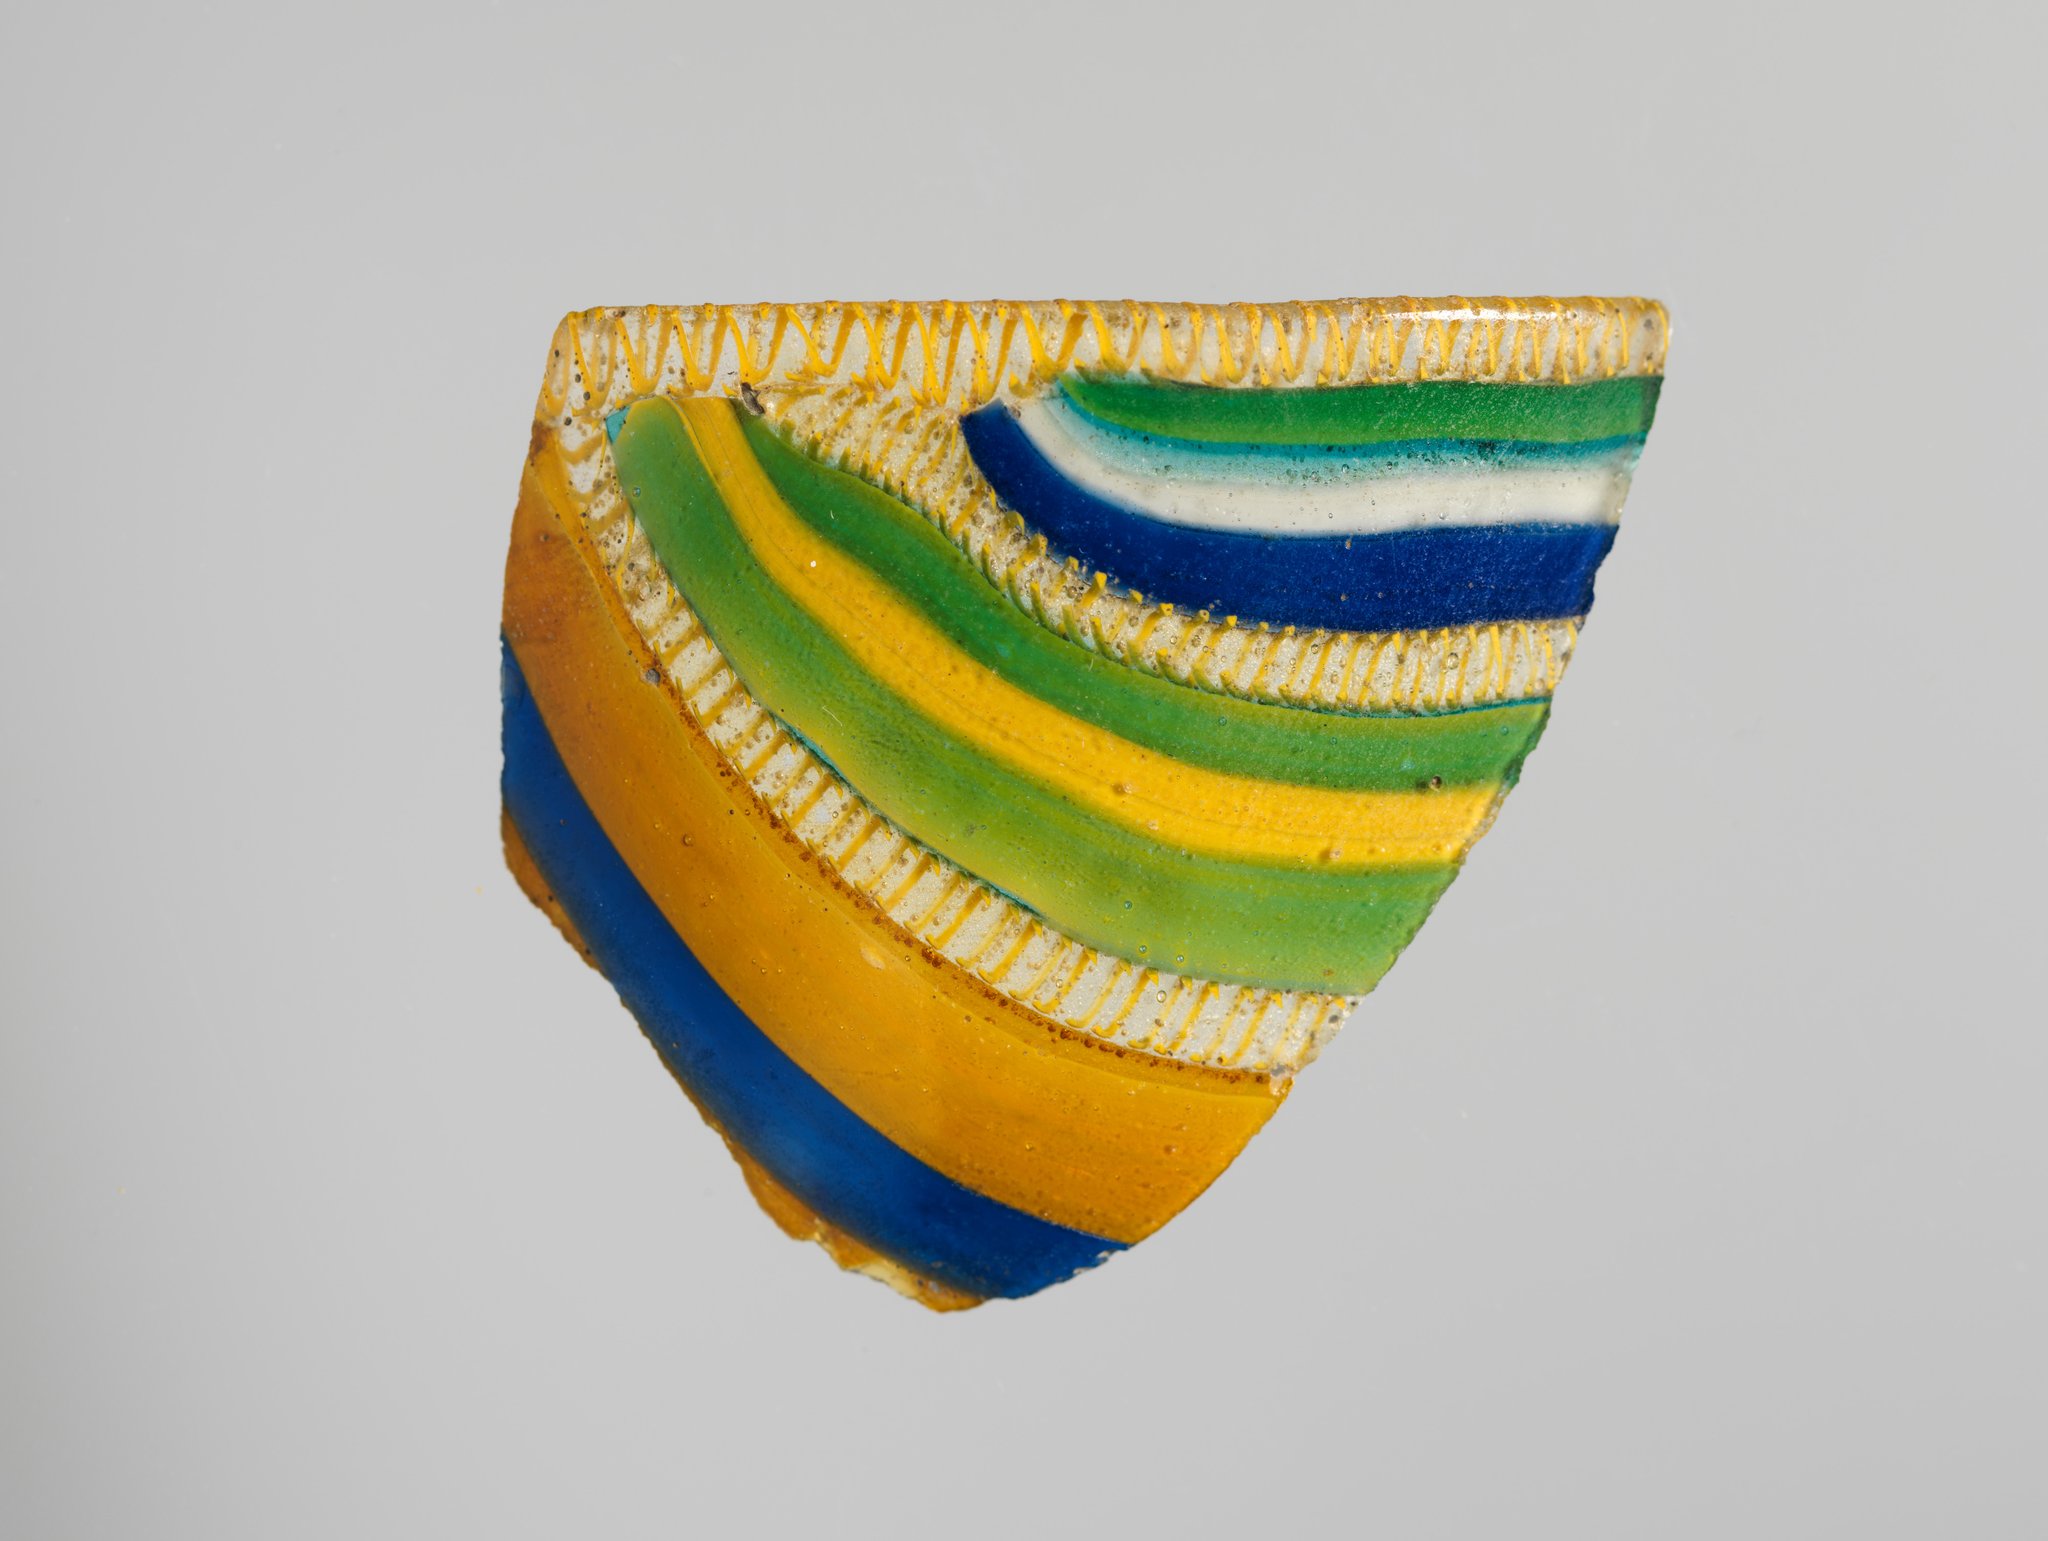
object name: fragment, striped mosaic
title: Glass striped mosaic bowl fragment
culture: roman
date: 34 BCE-33 CE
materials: glass